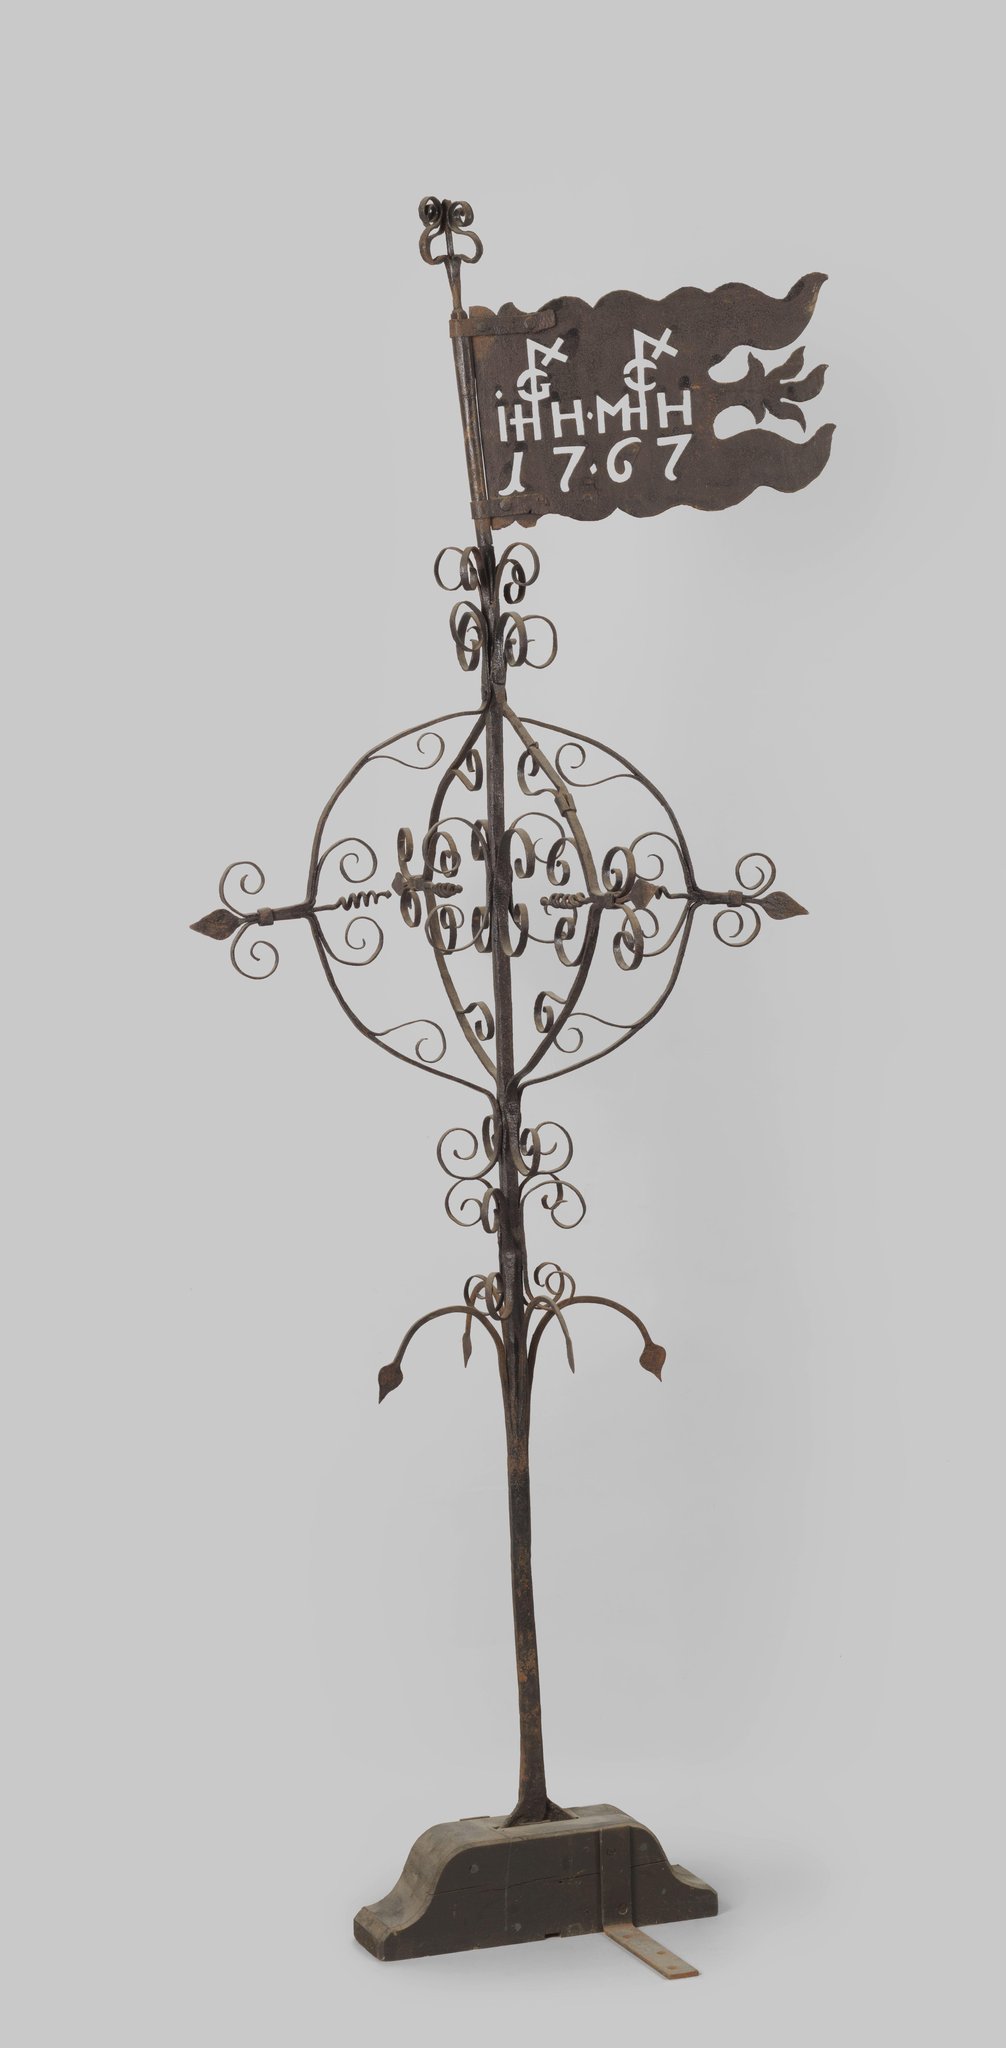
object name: weather vane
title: Windwijzer met vaan (gemerkt en gedateerd 1767)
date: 1767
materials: iron